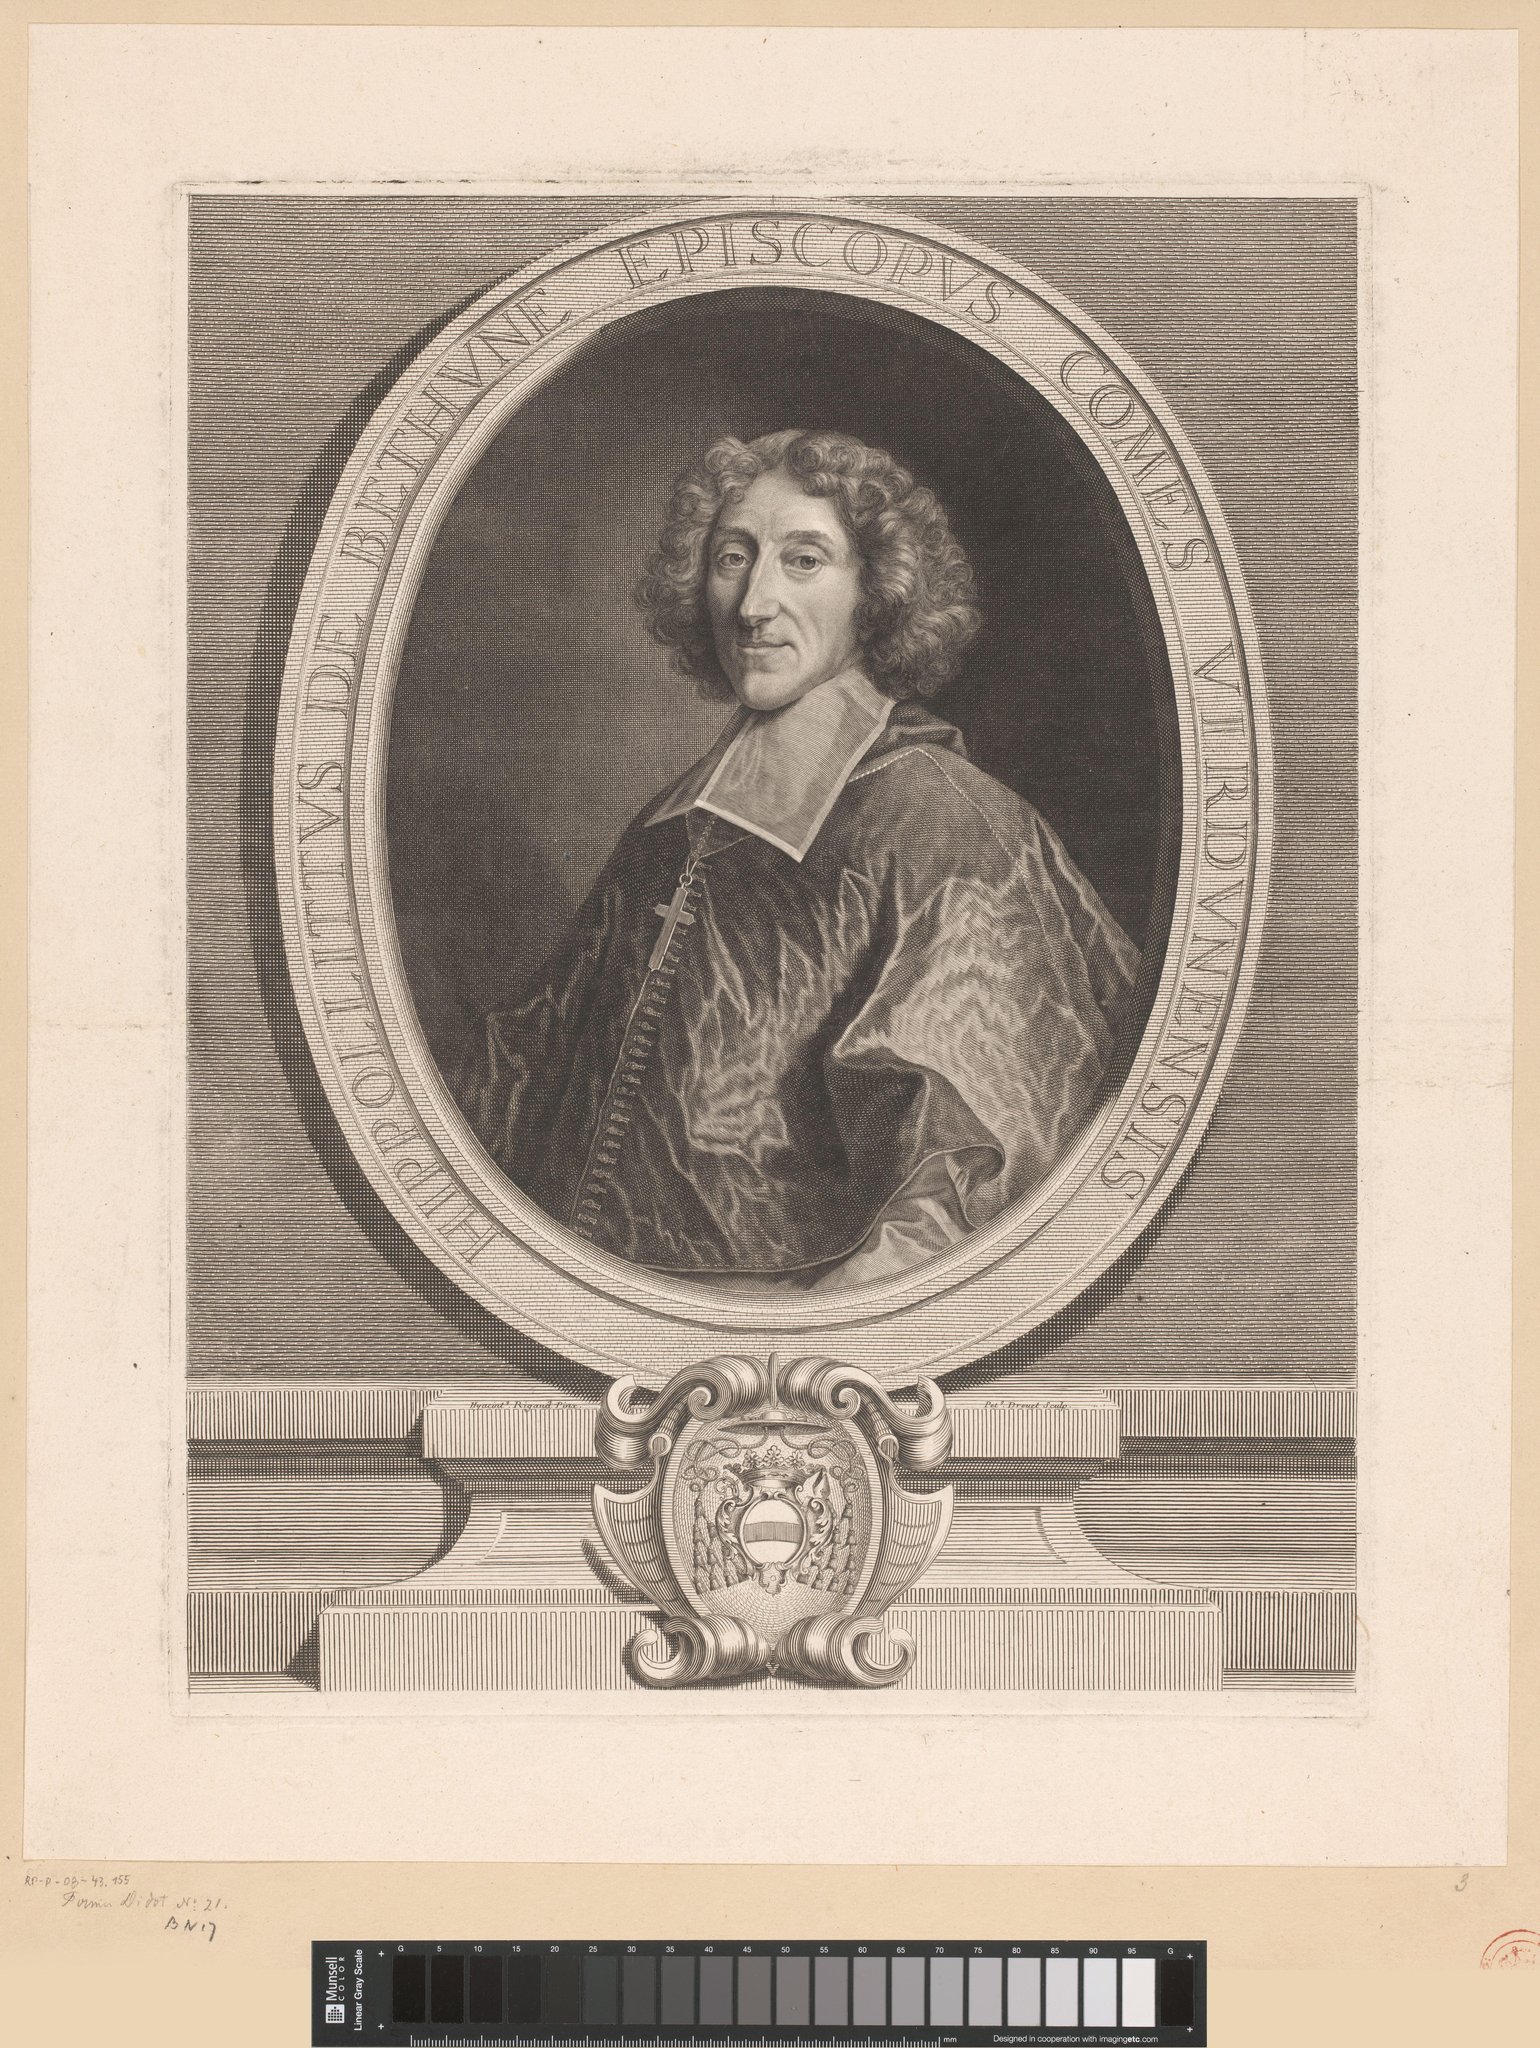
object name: print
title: Hippollittus de Bethune episcopus comes Virdunensis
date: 1673-1738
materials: paper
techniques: engraving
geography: france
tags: ornament ~ medallion, historical persons, prelates, e.g. archdeacon, canon (roman catholic), armorial bearing, heraldry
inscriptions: collector's mark: Lugt 240